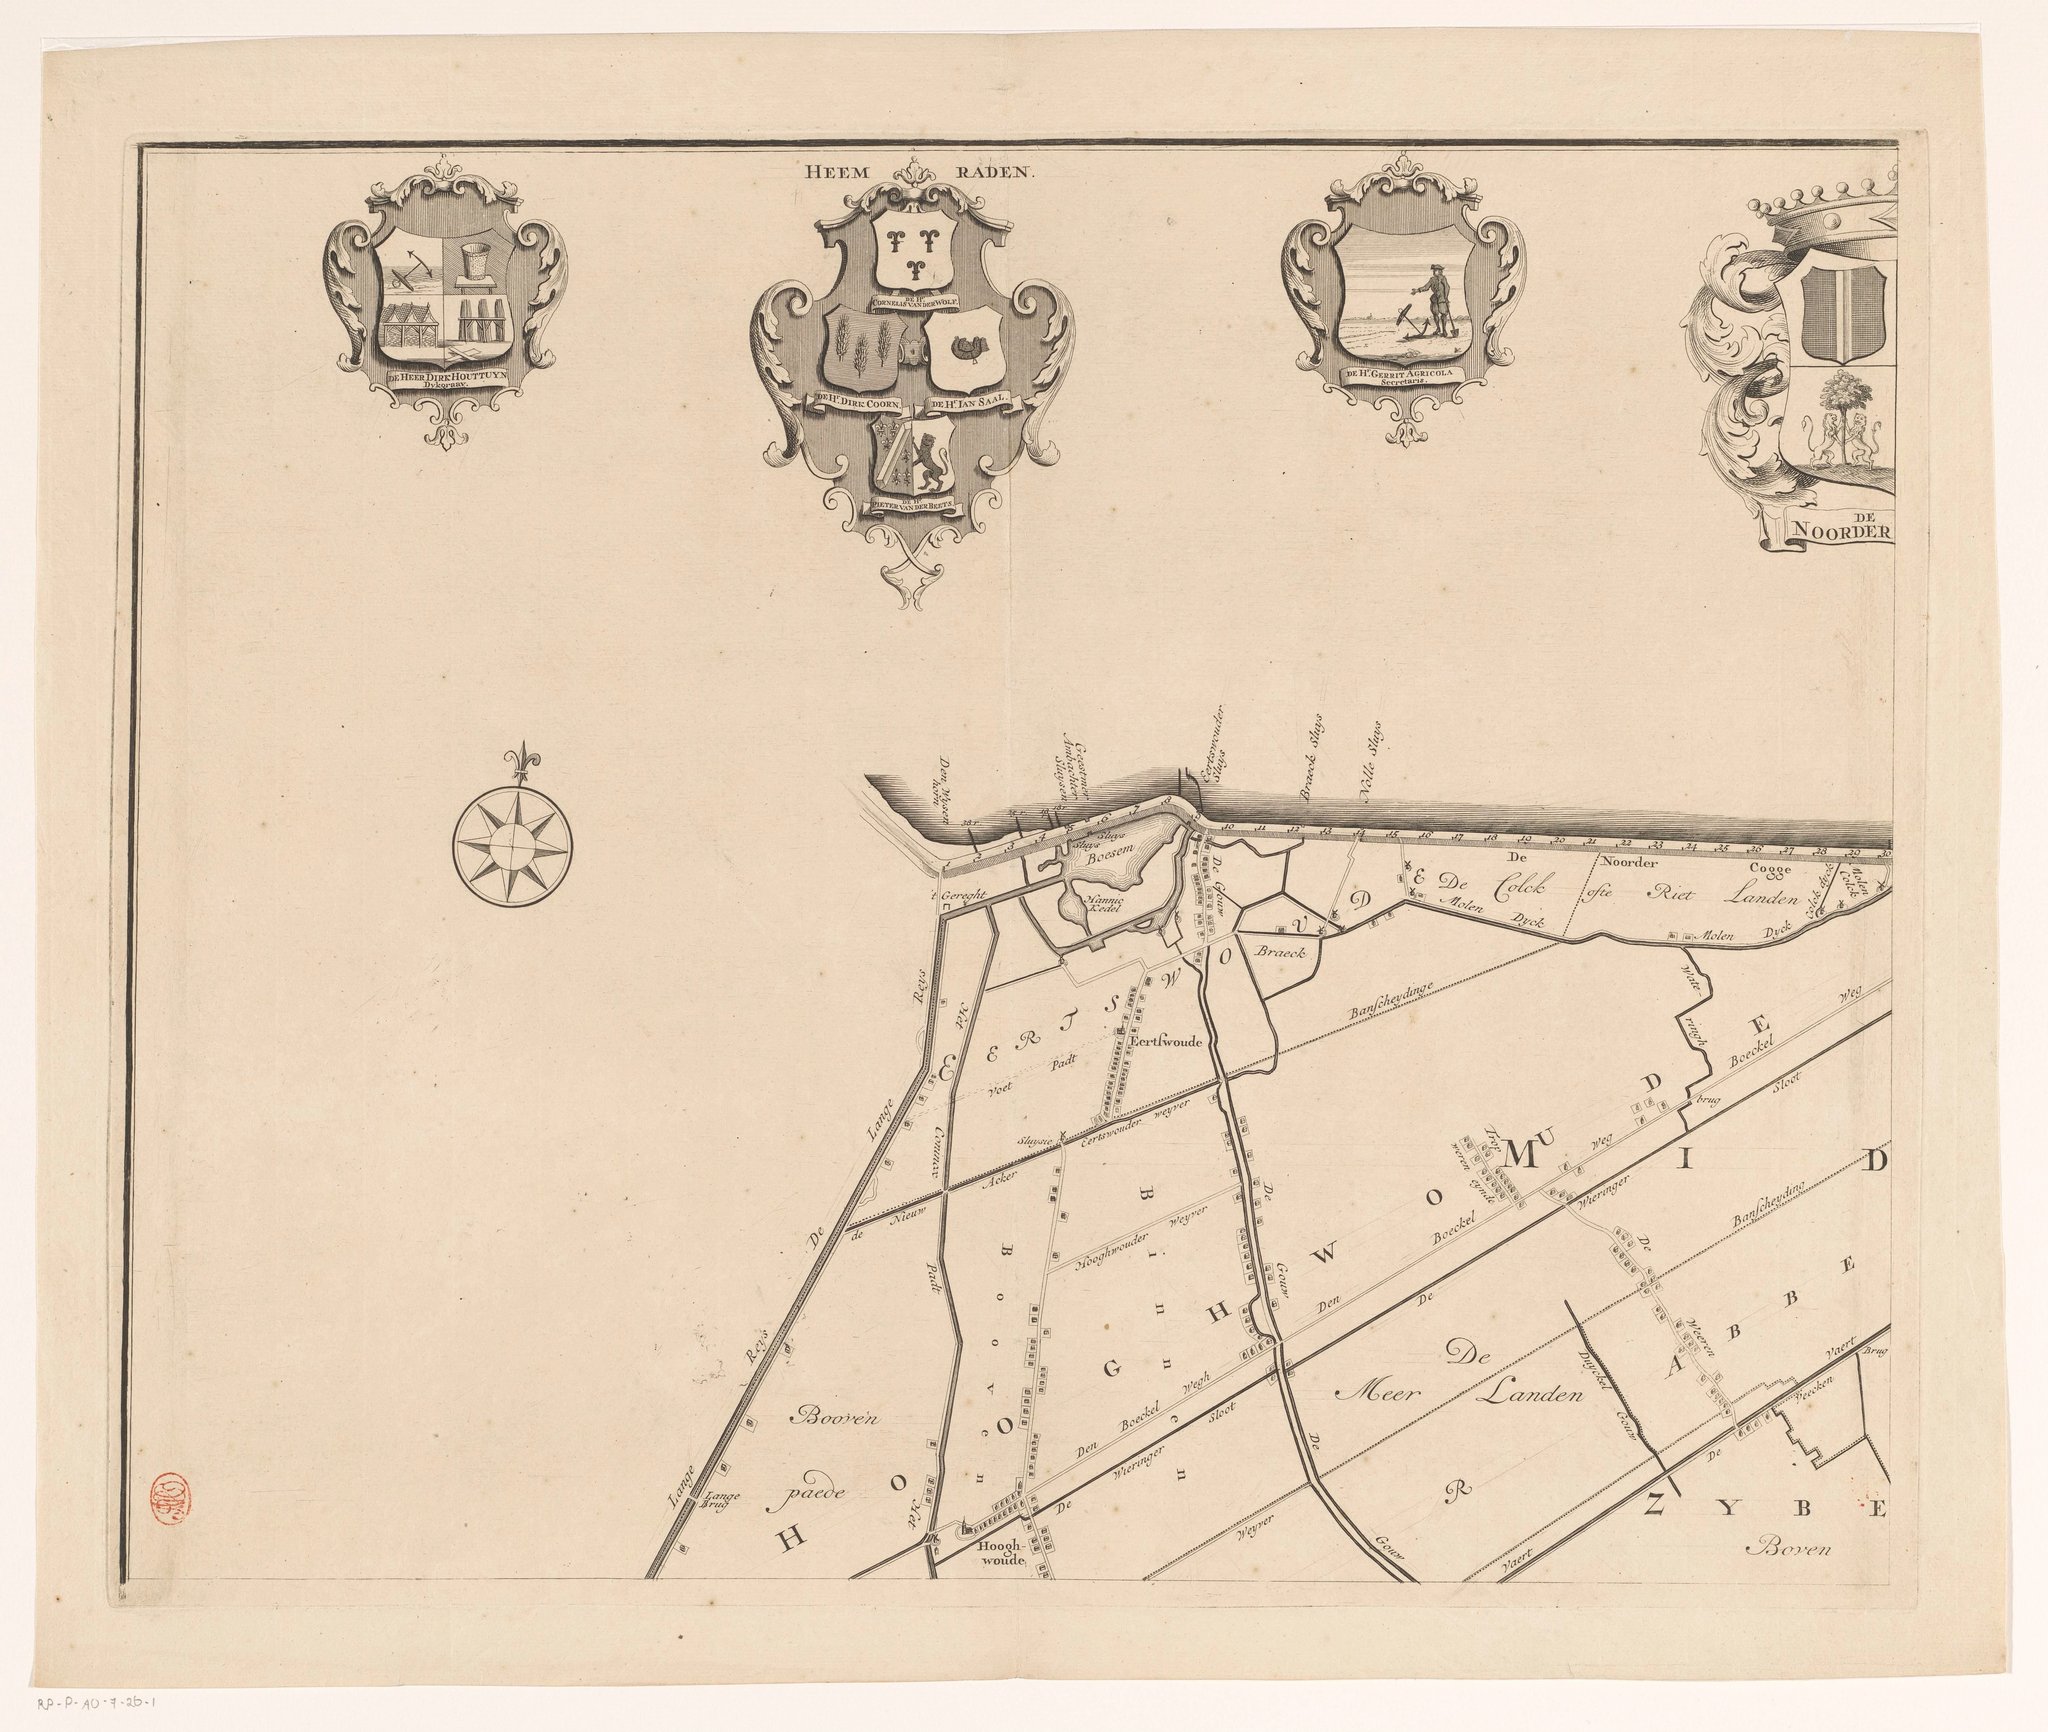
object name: print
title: Kaart van het dijkgraafschap van de Vier Noorder Koggen (deel linksboven)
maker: hendrik de leth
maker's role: draughtsman, print maker, publisher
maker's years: 1703-1766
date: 1731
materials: paper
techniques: engraving, etching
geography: amsterdam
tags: coat of arms (as symbol of the state, etc.), maps of separate countries or regions, polder, reclaimed land, armorial bearing, heraldry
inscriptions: collector's mark: Lugt 195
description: Deel (linksboven) van een kaart van het dijkgraafschap de Vier Noorder Koggen.